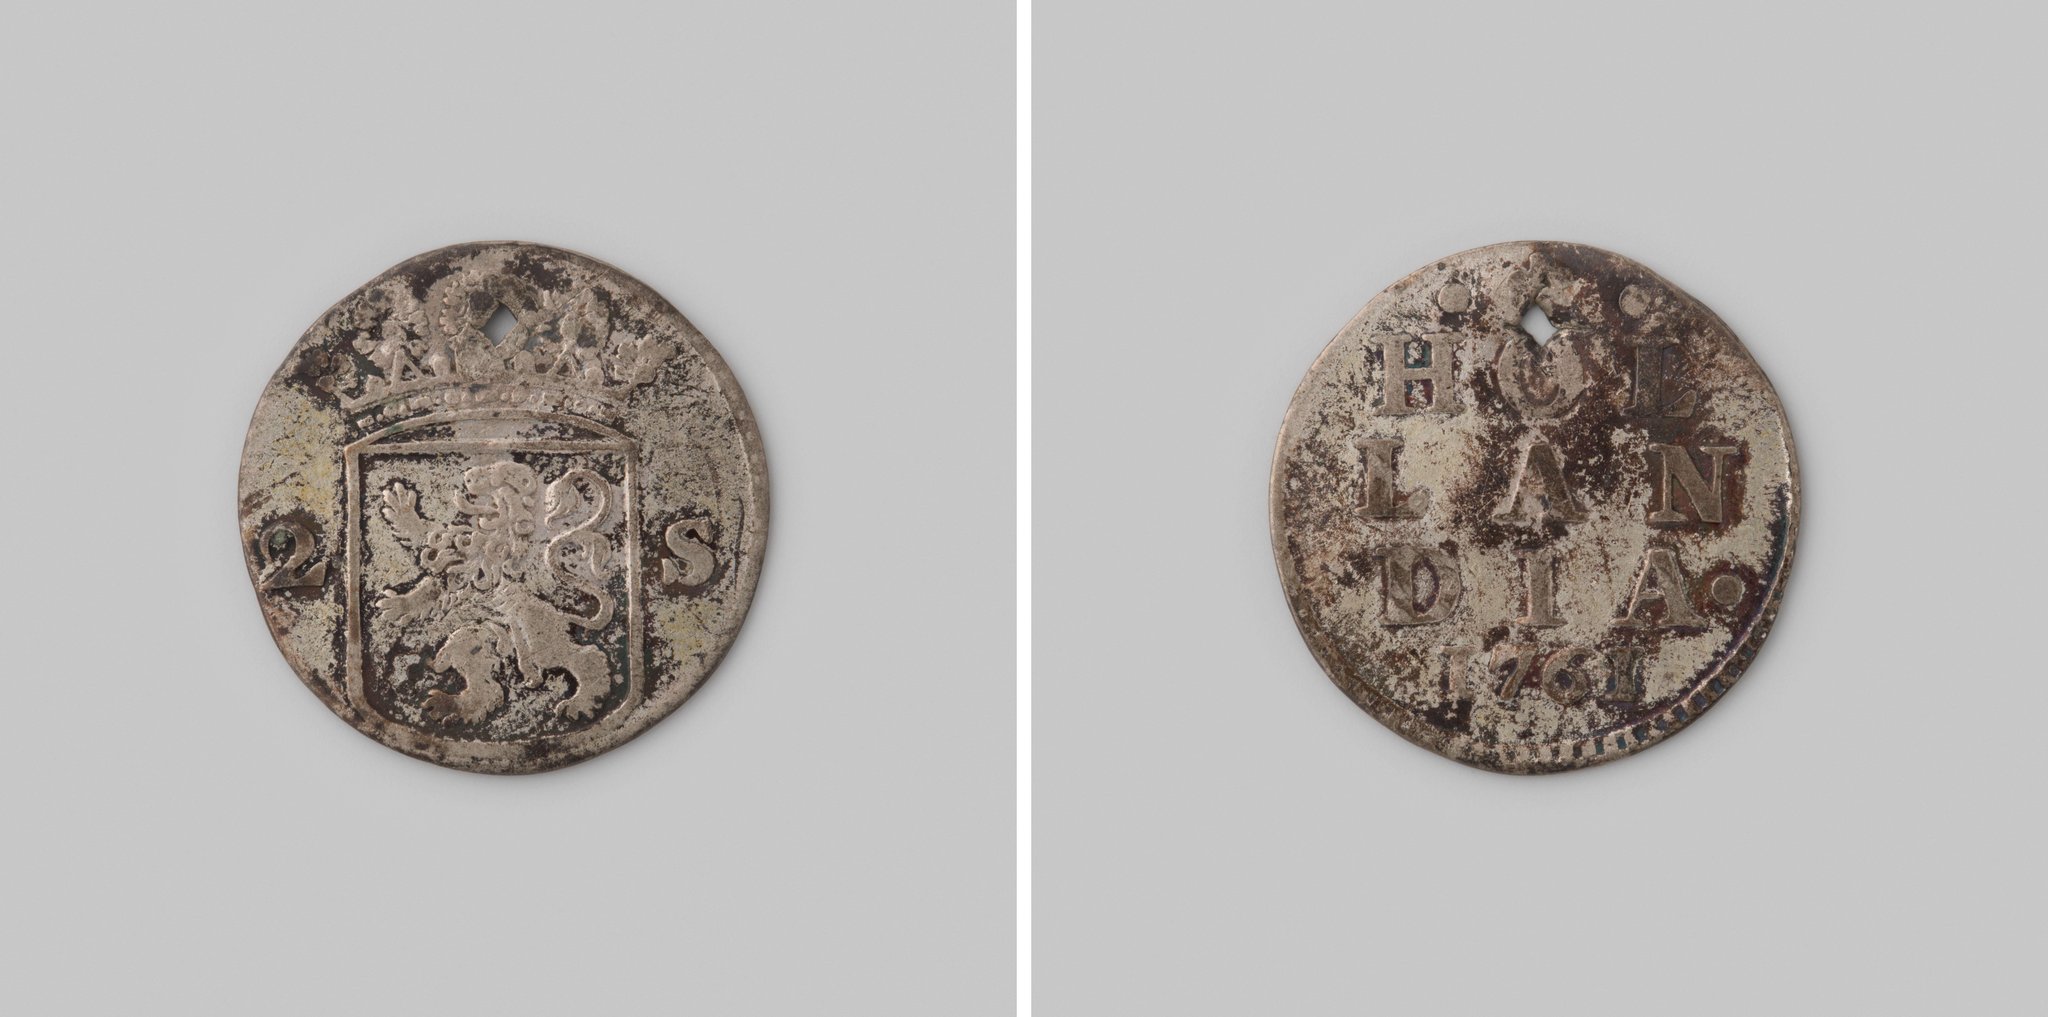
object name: coin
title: Holland, dubbele stuiver, 1761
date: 1761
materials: silver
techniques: striking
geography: dordrecht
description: Zilveren munt. Voorzijde: tussen waarde-aanduiding 2 S gekroond wapenschild van Holland. Keerzijde: opschrift: provincienaam in drie regels, daaronder jaartal.